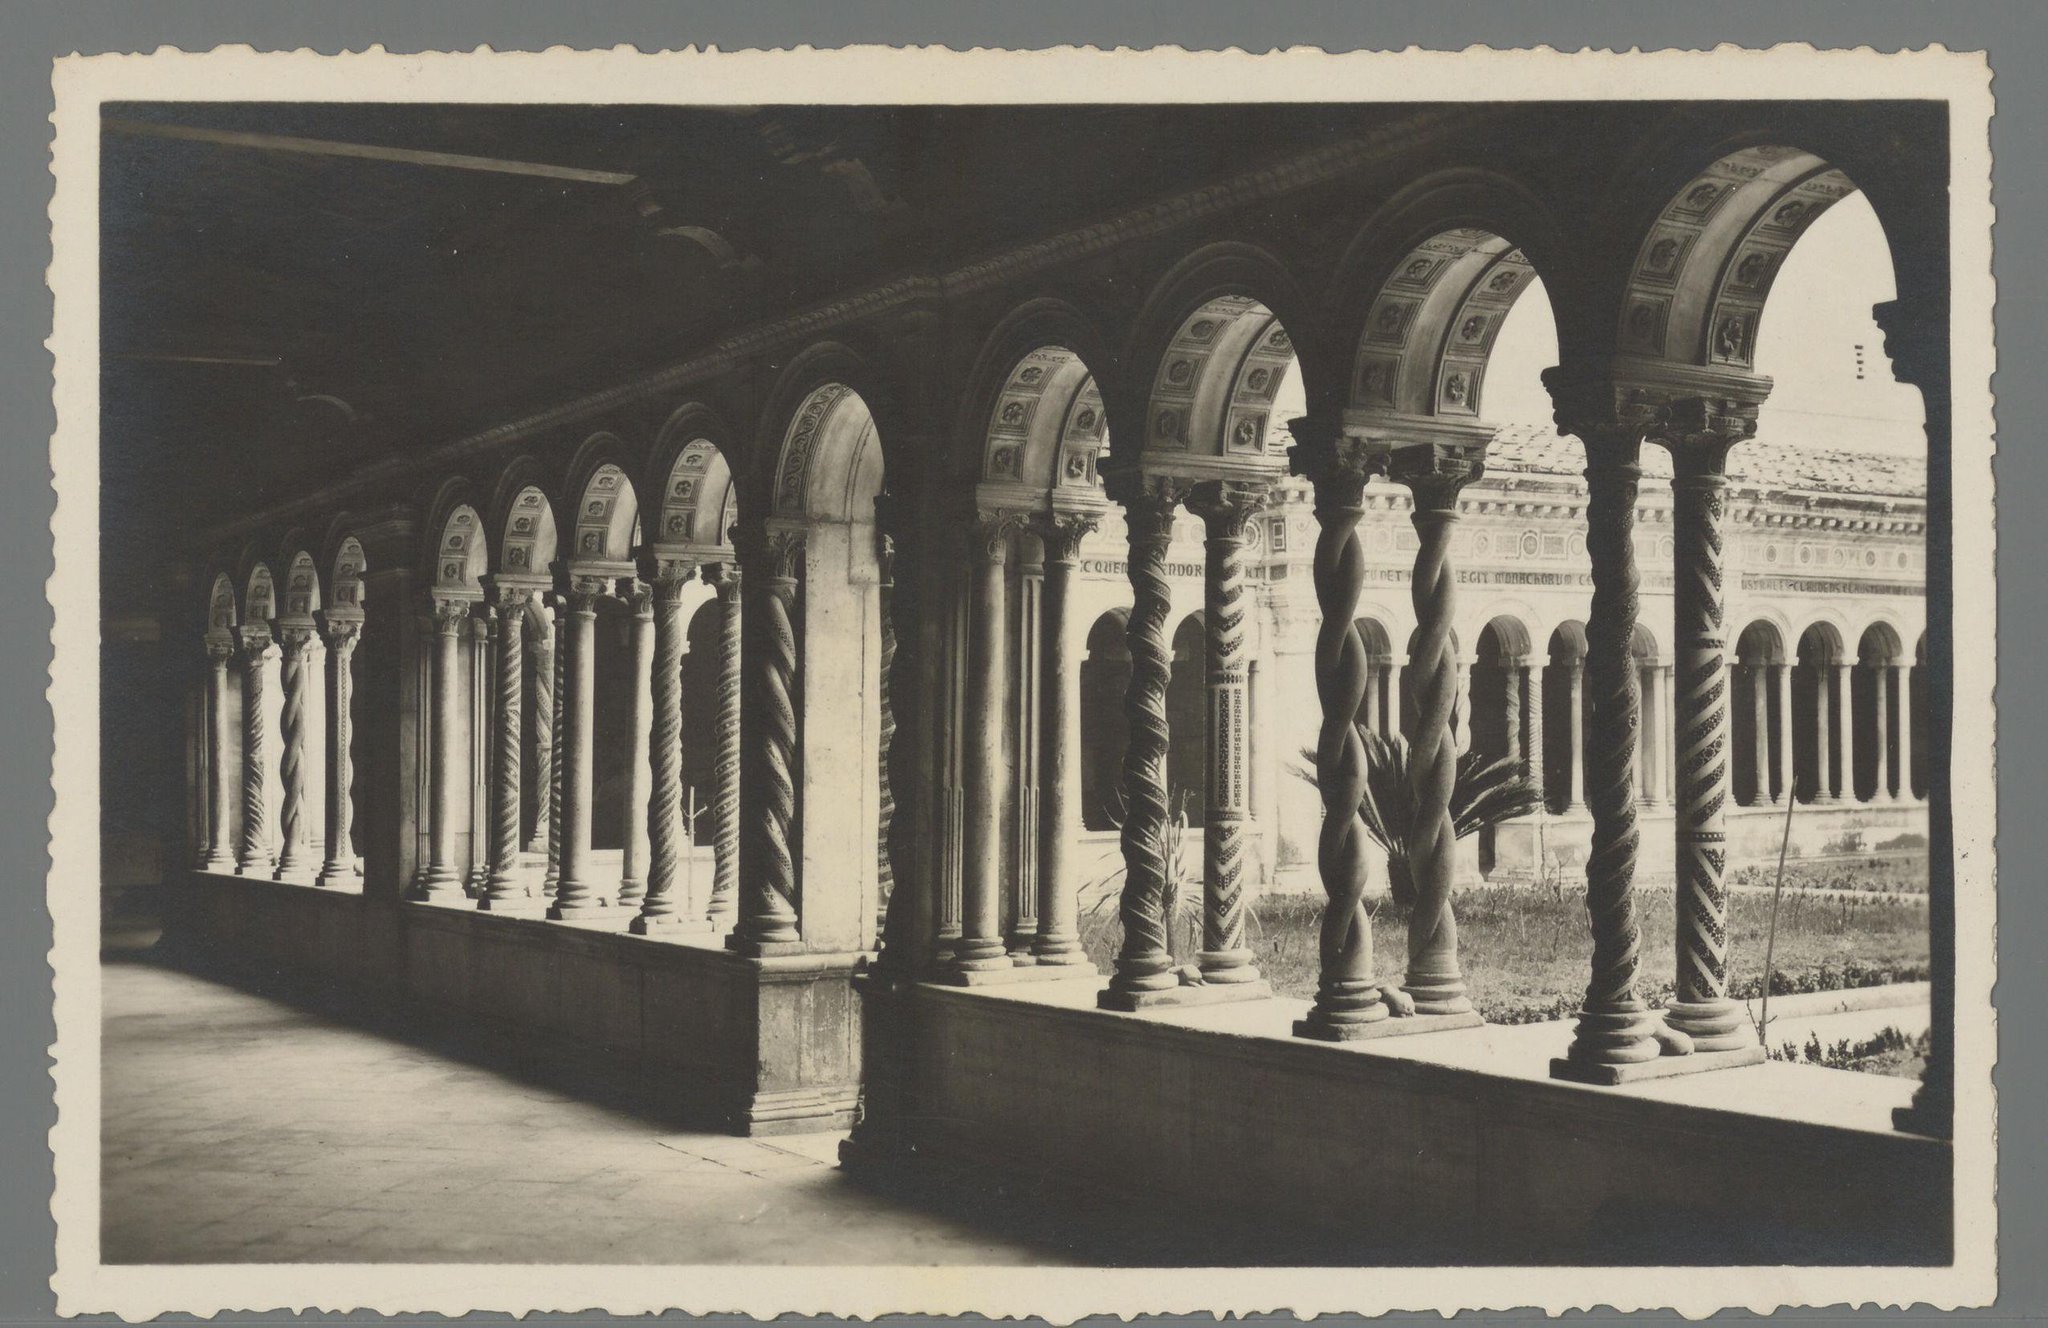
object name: ansichtkaart, prentbriefkaart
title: Roma. Chiostro di S. Paolo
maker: Anonymous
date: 1931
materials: photographic support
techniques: photography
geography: rome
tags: cloisters ~ monastery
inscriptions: date